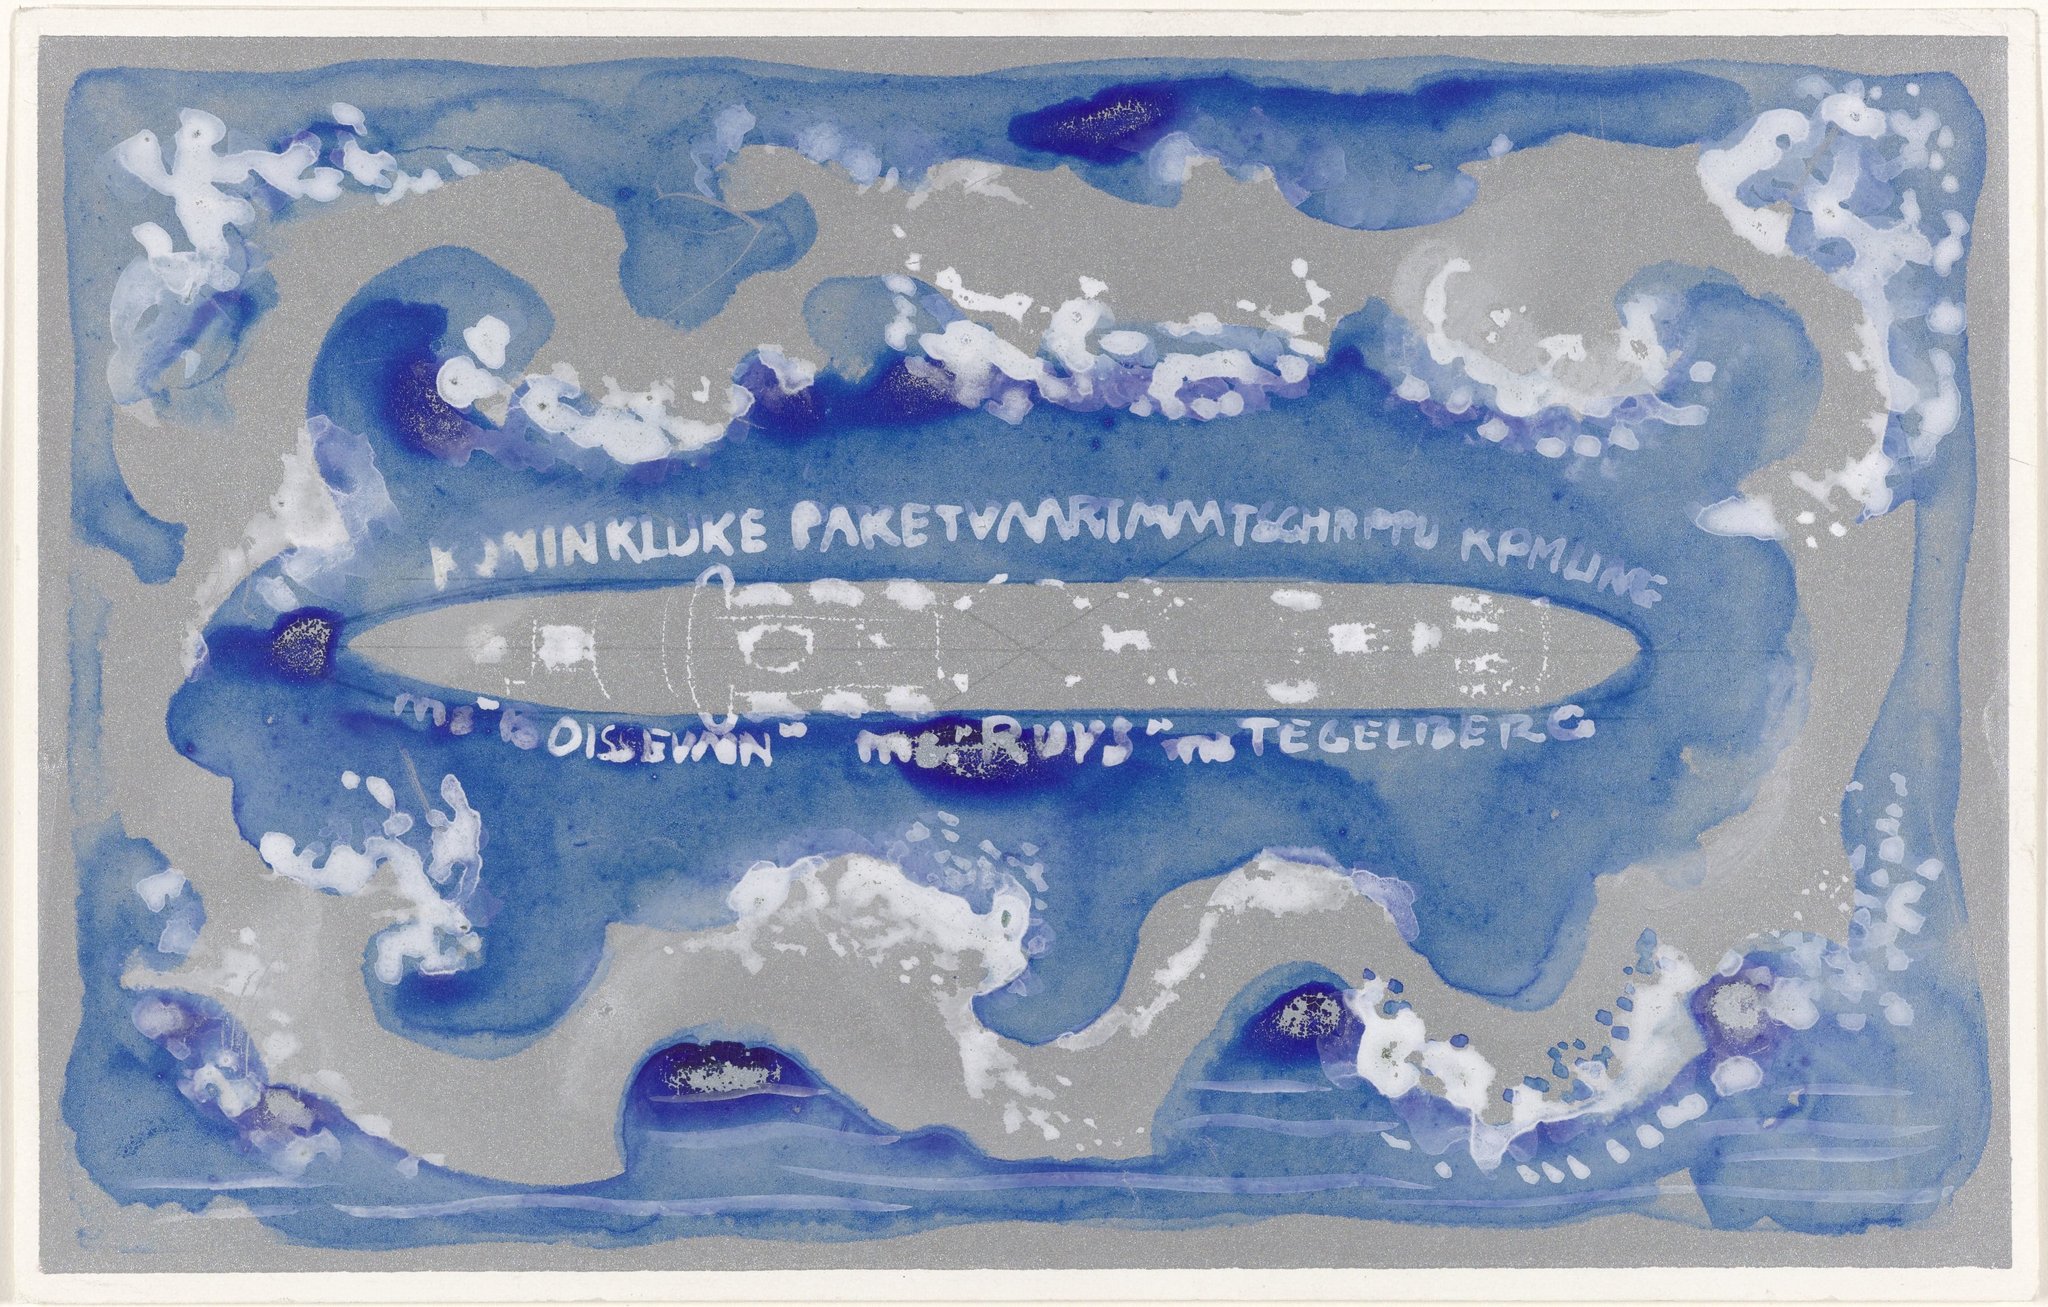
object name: drawing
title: Ontwerp voor een vignet voor de Koninklijke Paketvaart Maatschappij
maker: carel adolph lion cachet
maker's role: draughtsman, print maker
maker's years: 1864-1945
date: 1874-1945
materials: pencil, paper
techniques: brush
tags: names of organizations, companies, trade unions, etc., ships (in general)